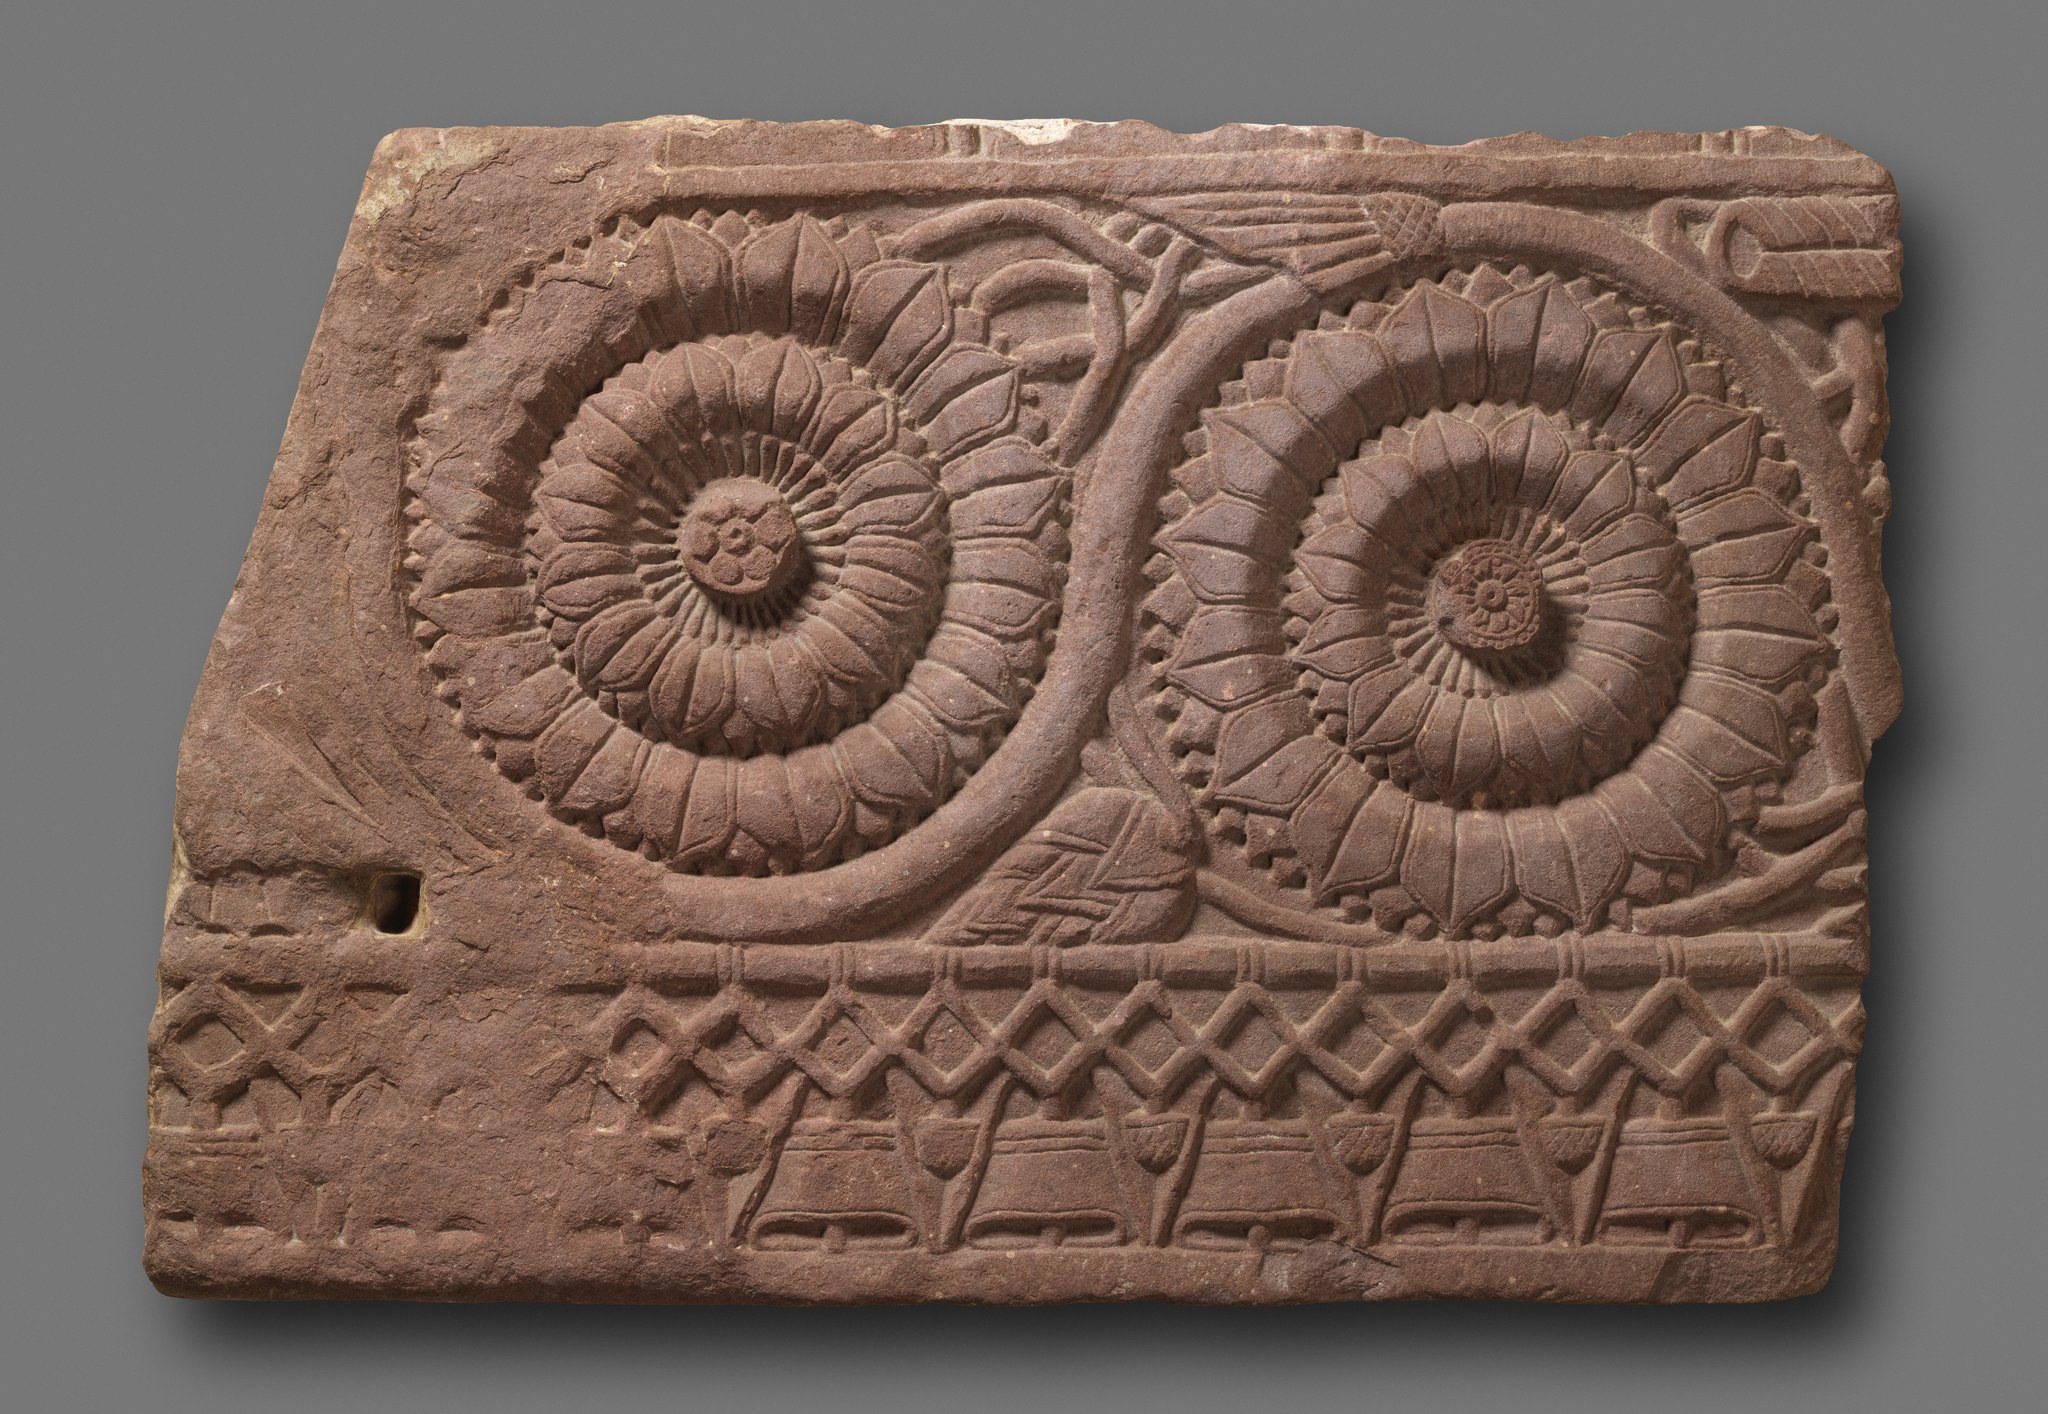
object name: architectural relief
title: Two Lotuses, from the Bharhut Stupa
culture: indian, madhya pradesh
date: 100-1 BCE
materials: stone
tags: shunga,lotuses